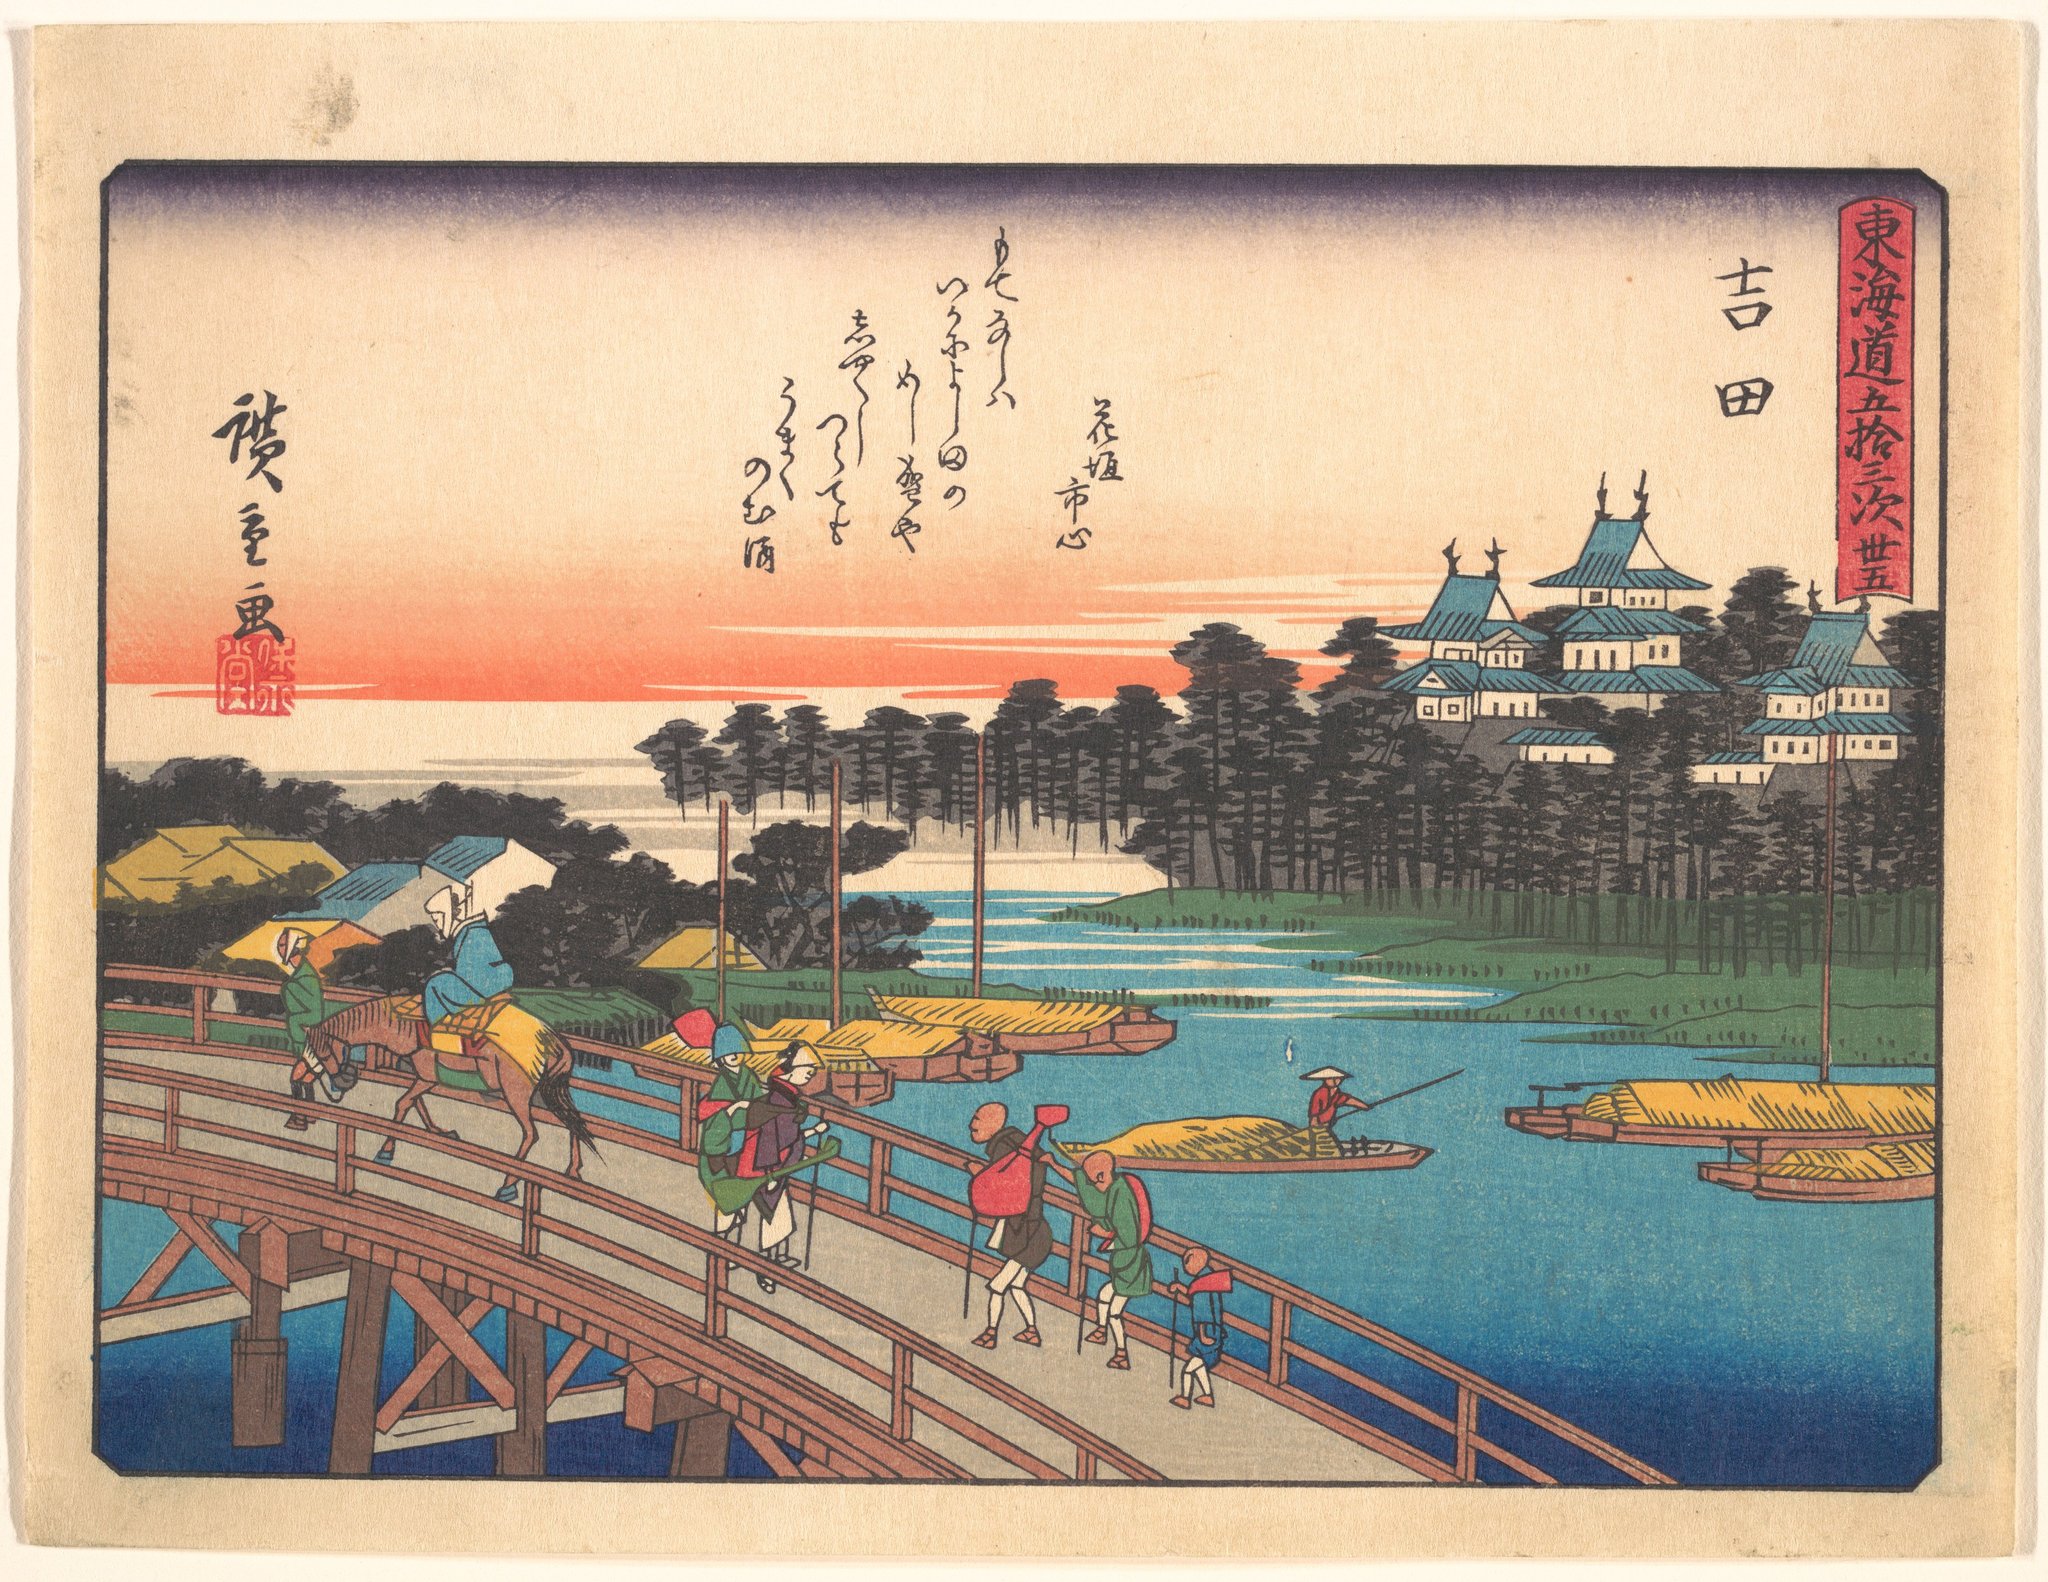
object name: print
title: Yoshida, from the series The Fifty-three Stations of the Tōkaidō Road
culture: japanese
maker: utagawa hiroshige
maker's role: artist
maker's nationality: japanese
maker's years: 1797-1858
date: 1901-1933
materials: ink, paper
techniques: woodblock print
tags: houses,bridges,horses,trees,boats